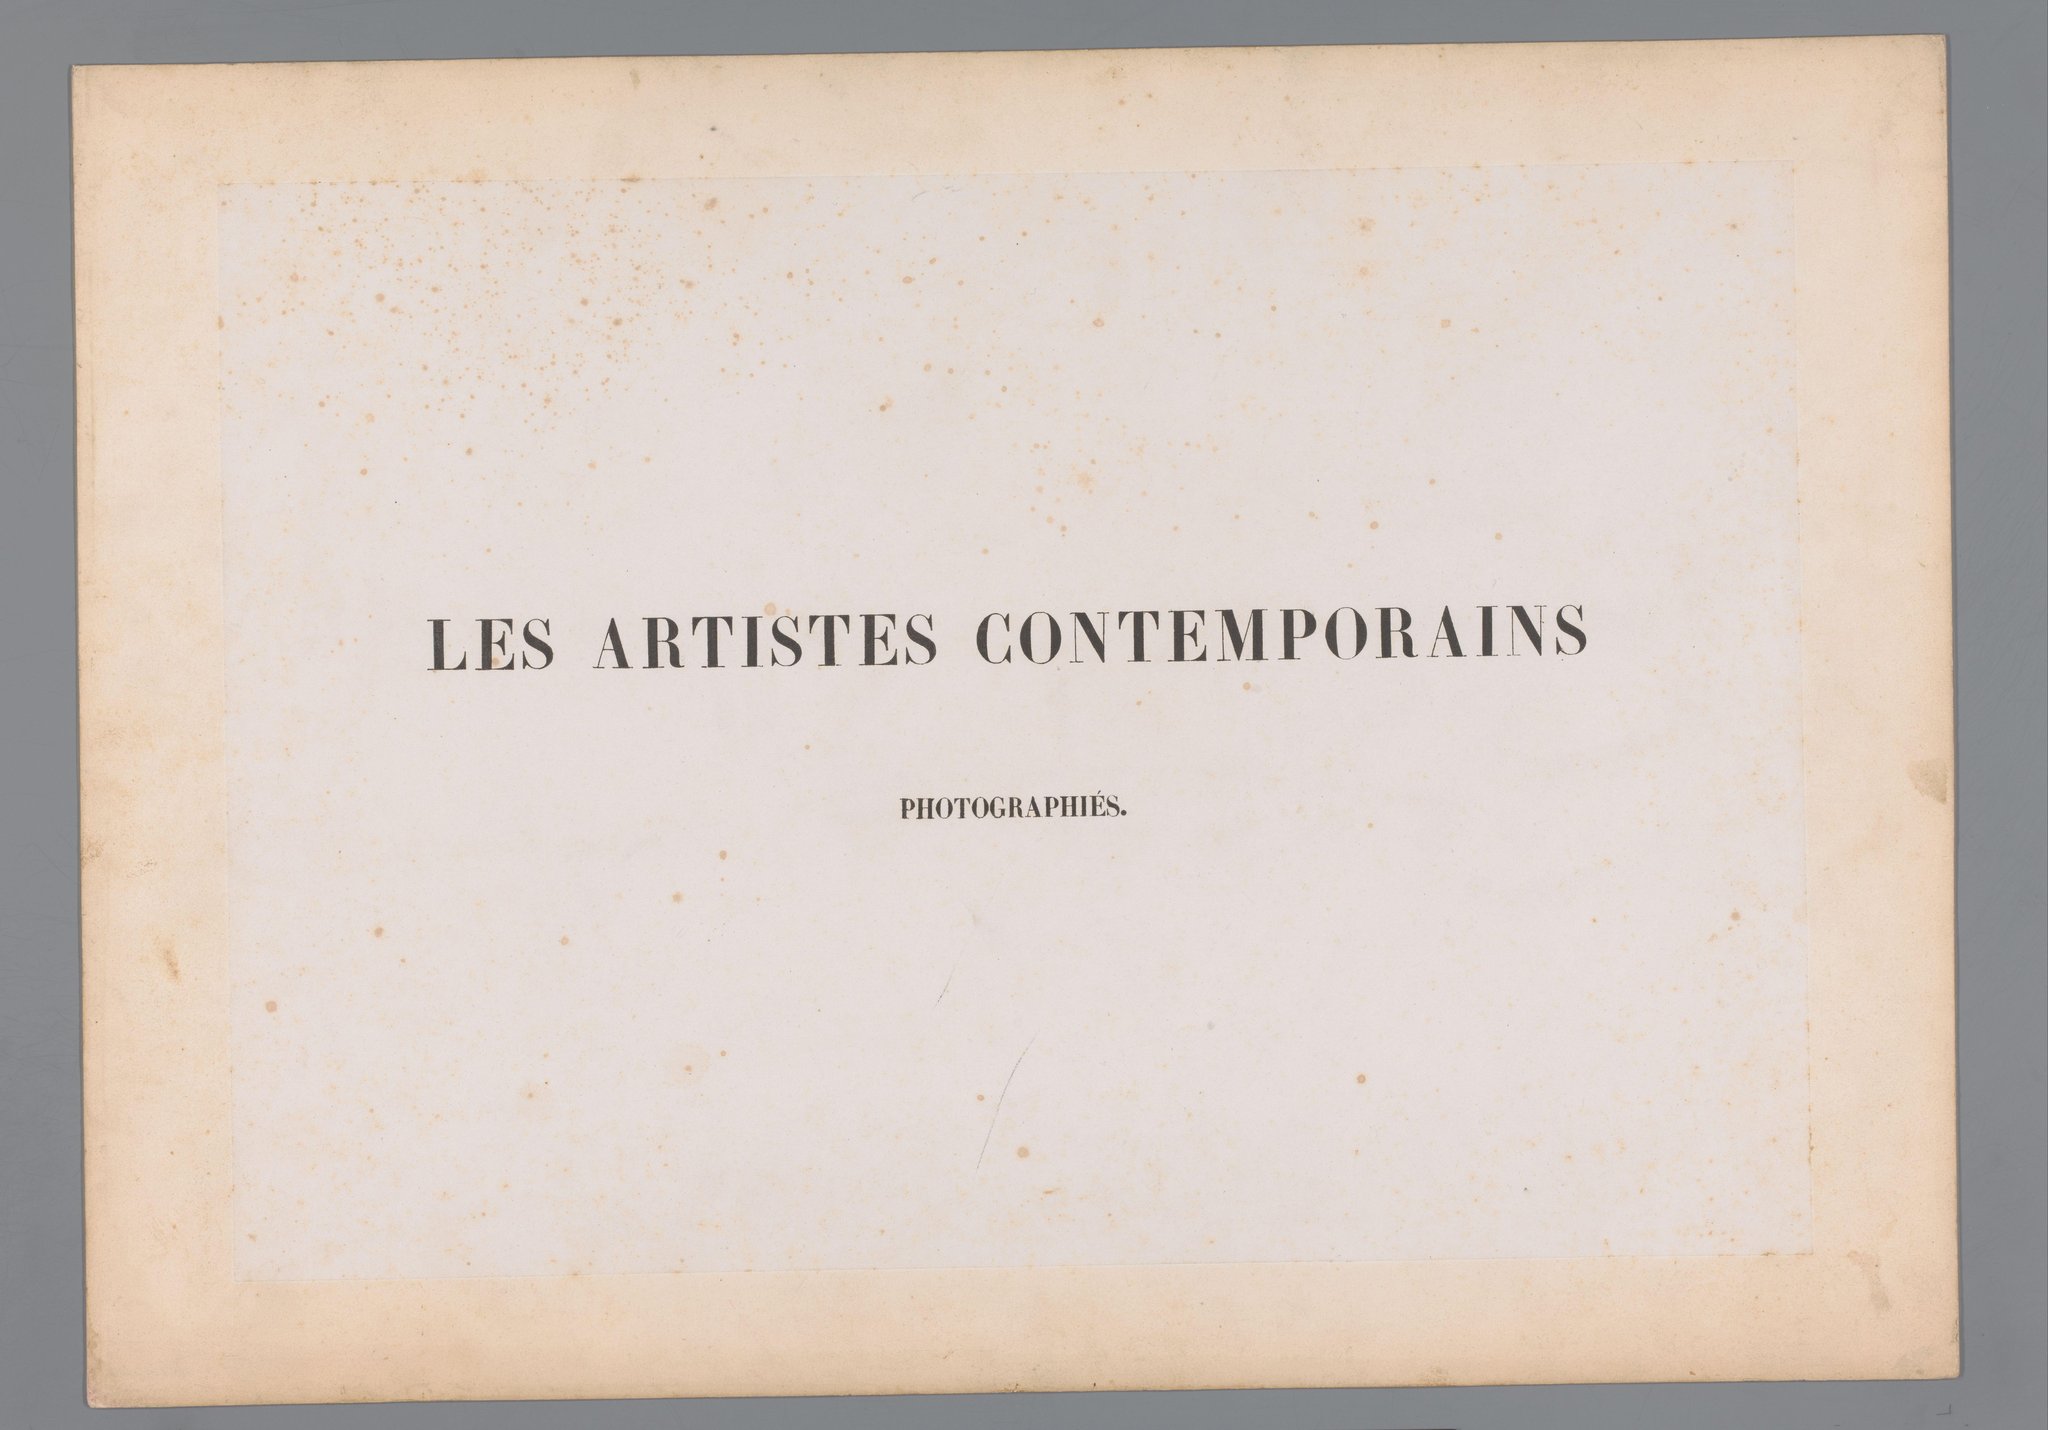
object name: wrapper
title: Les artistes contemporains photographiés / par E. Fierlants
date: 1863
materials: cardboard, leather, linen, paper, photographic support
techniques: albumen print, printing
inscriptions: date: ‘JUL 1983’, bookplate: ‘EX/ SFJ/ LIBRIS’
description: Omslag met twaalf foto's en twee tekstbladen.